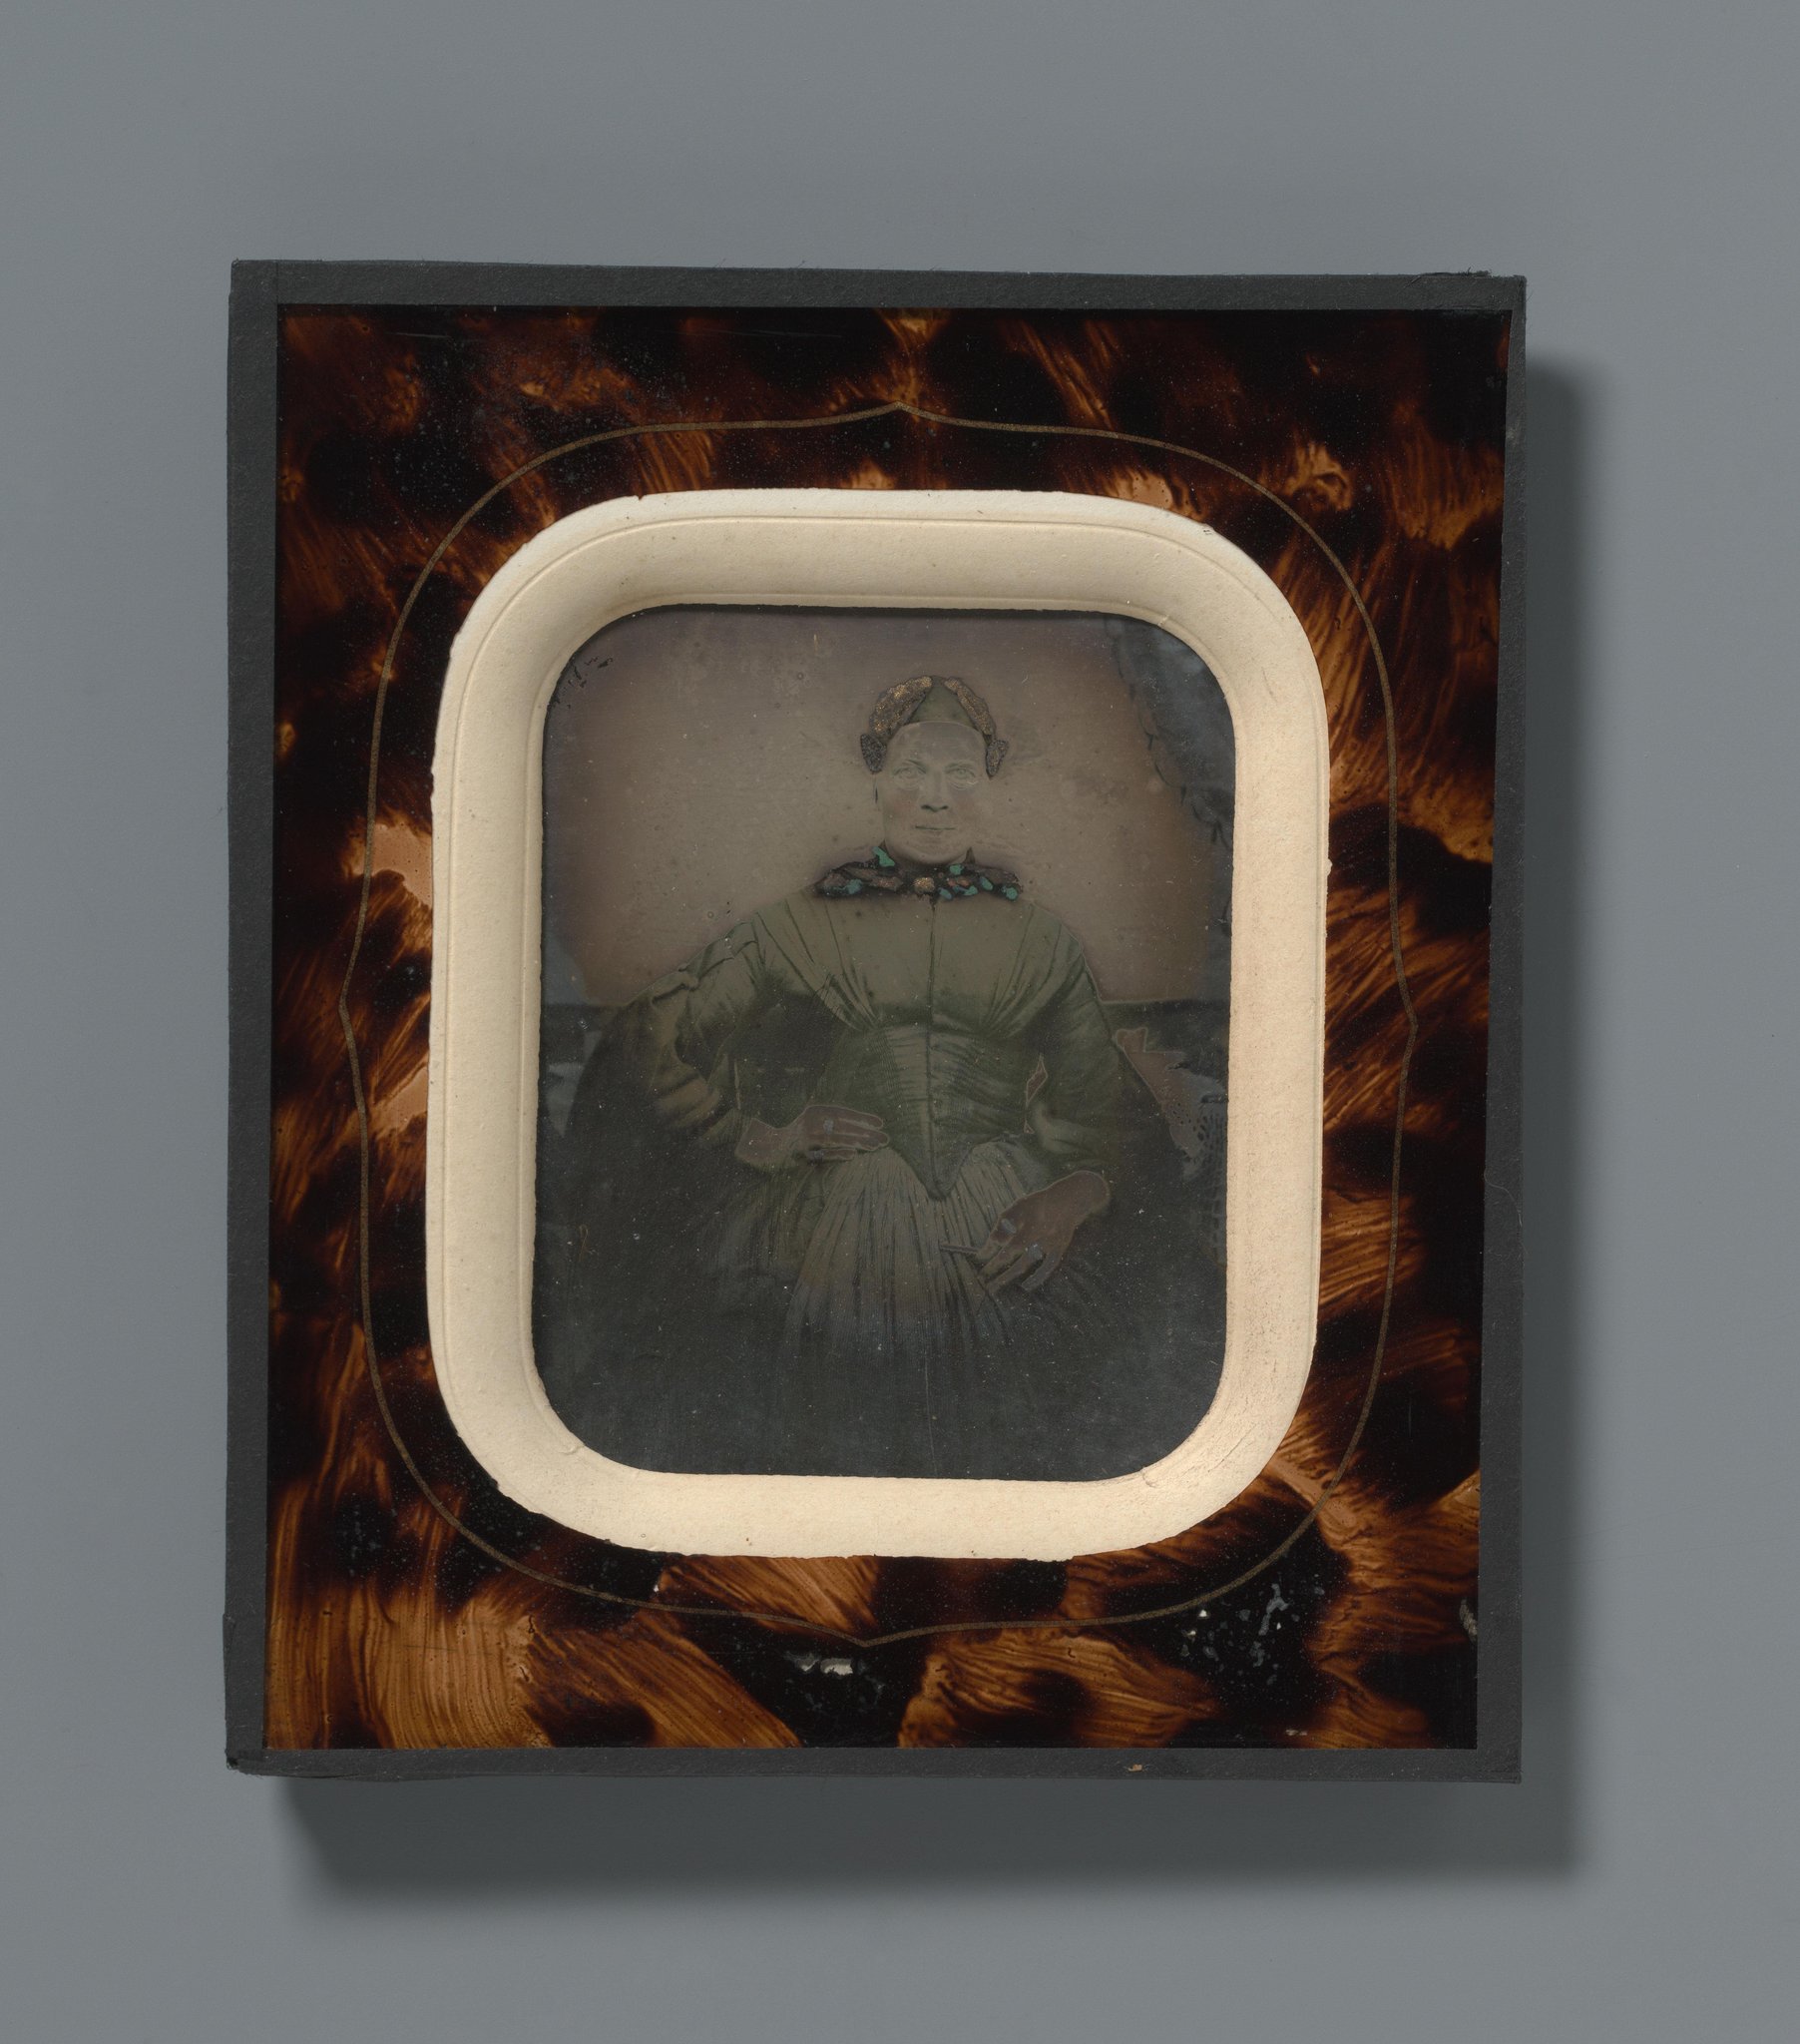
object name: frame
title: Portret van een onbekende Friese vrouw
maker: Anonymous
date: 1855-1870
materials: glass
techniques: ambrotype, hand coloring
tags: historical persons - bb - woman, folk costume, regional costume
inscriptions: annotation: ‘Friesch [...]’